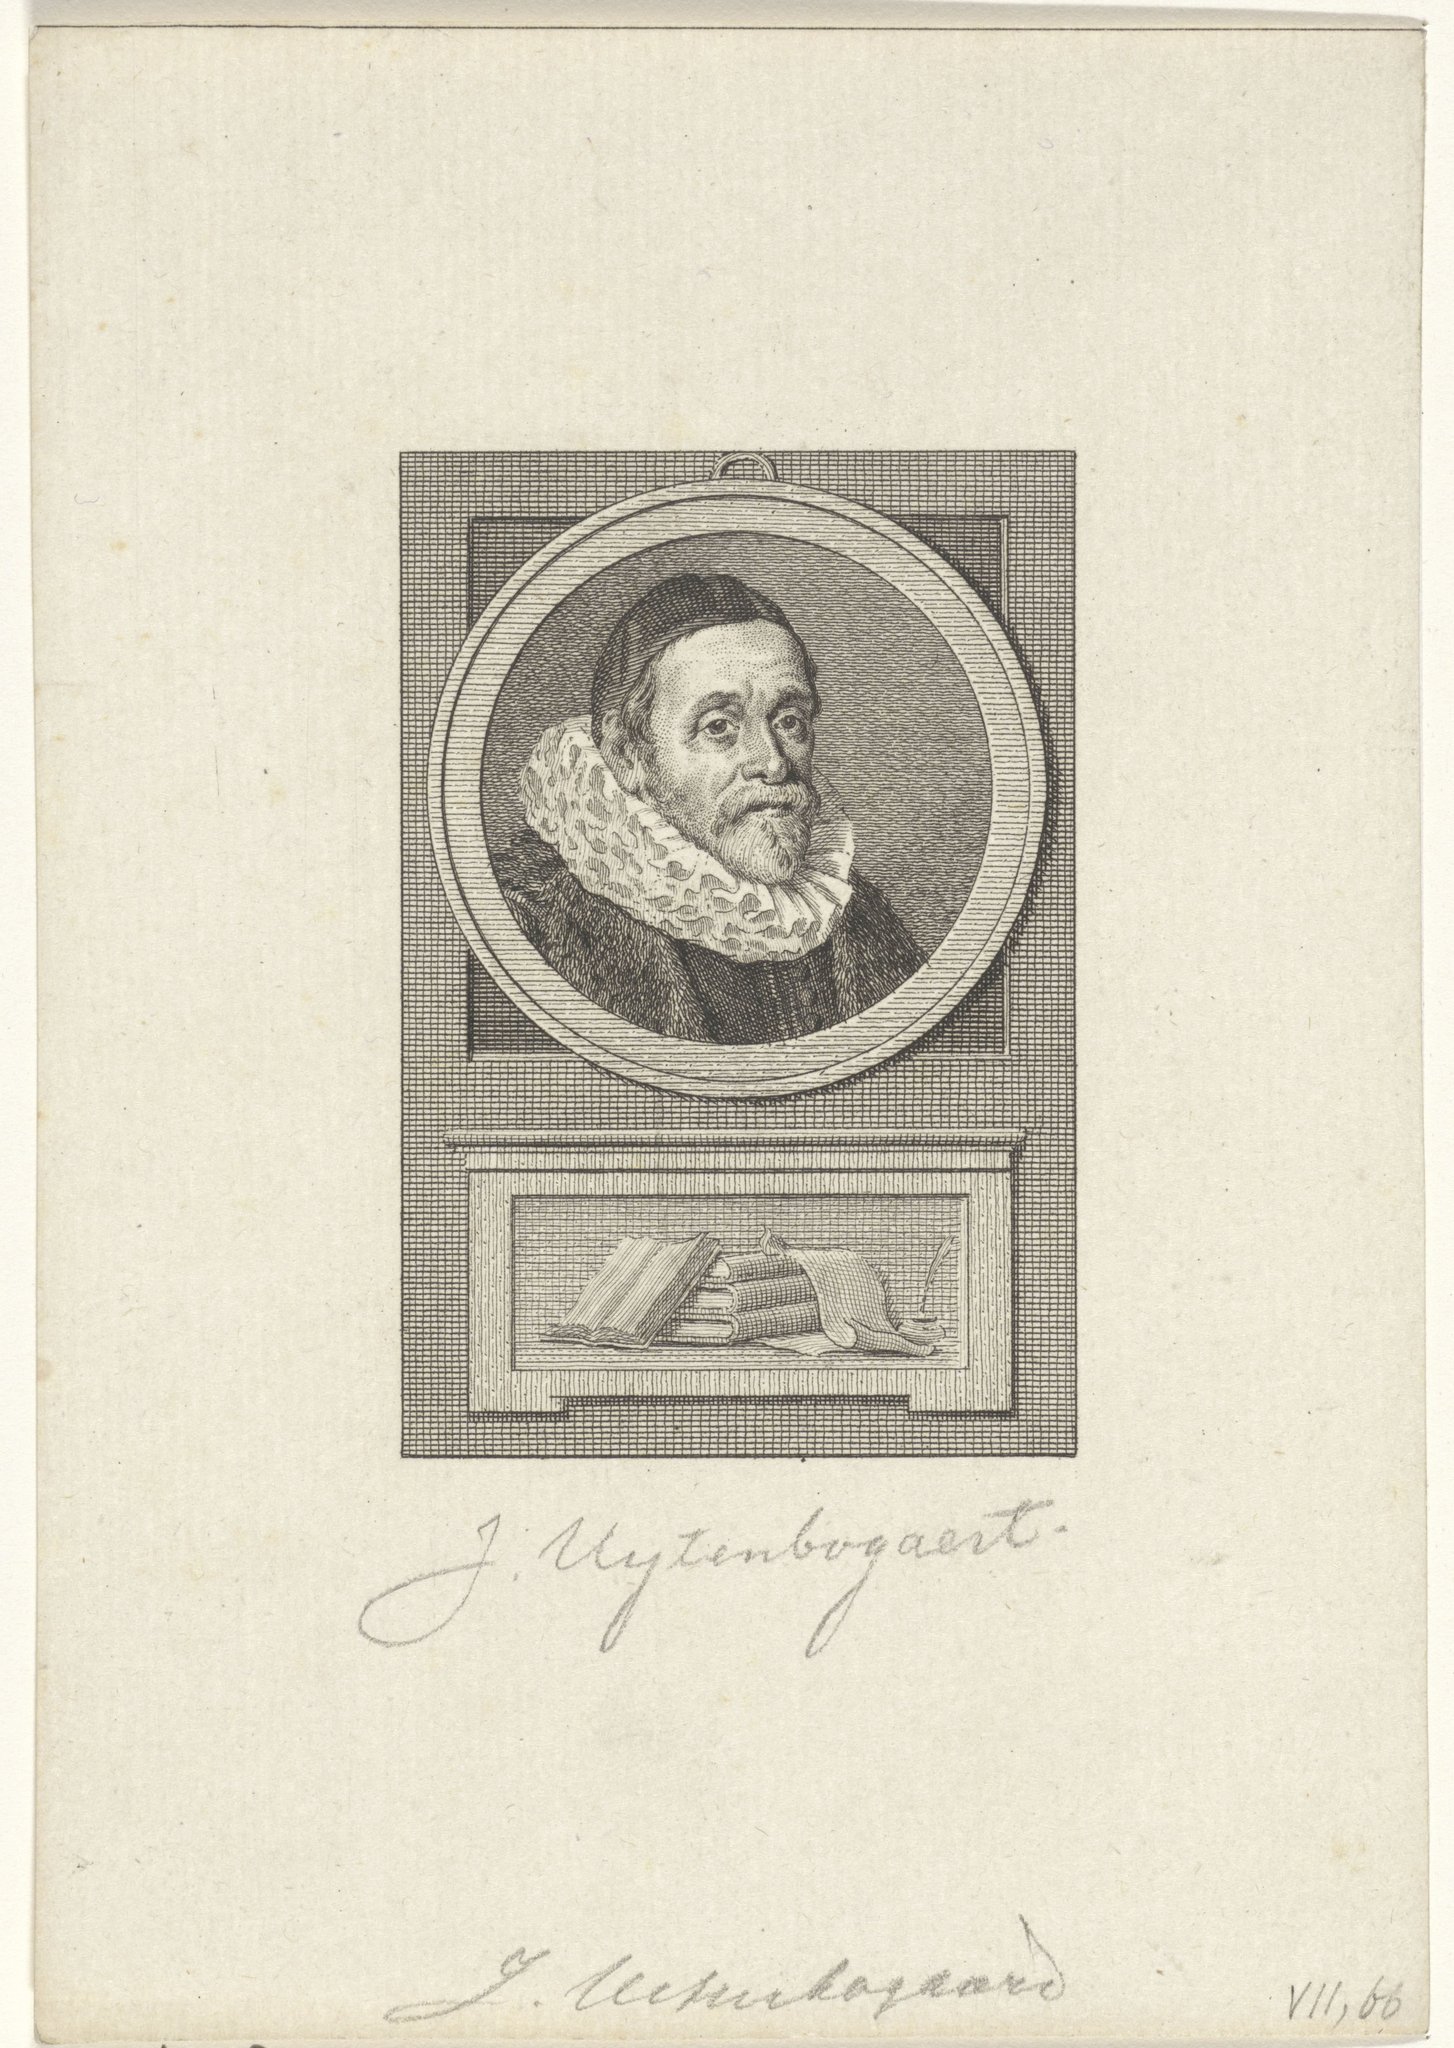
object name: print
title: Portret van Johannes Wtenbogaert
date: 1783-1795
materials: paper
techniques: engraving, etching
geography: amsterdam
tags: utrecht, the hague, quill, ink-well, book, paper (writing material)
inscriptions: collector's mark: Lugt 2228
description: Portret van Johannes Wtenbogaert, raadsman van Van Oldebarnevelt en hofpredikant van stadhouder prins Maurits. Onder het portret boeken, een vel papier en een inkpot met schrijfveer.